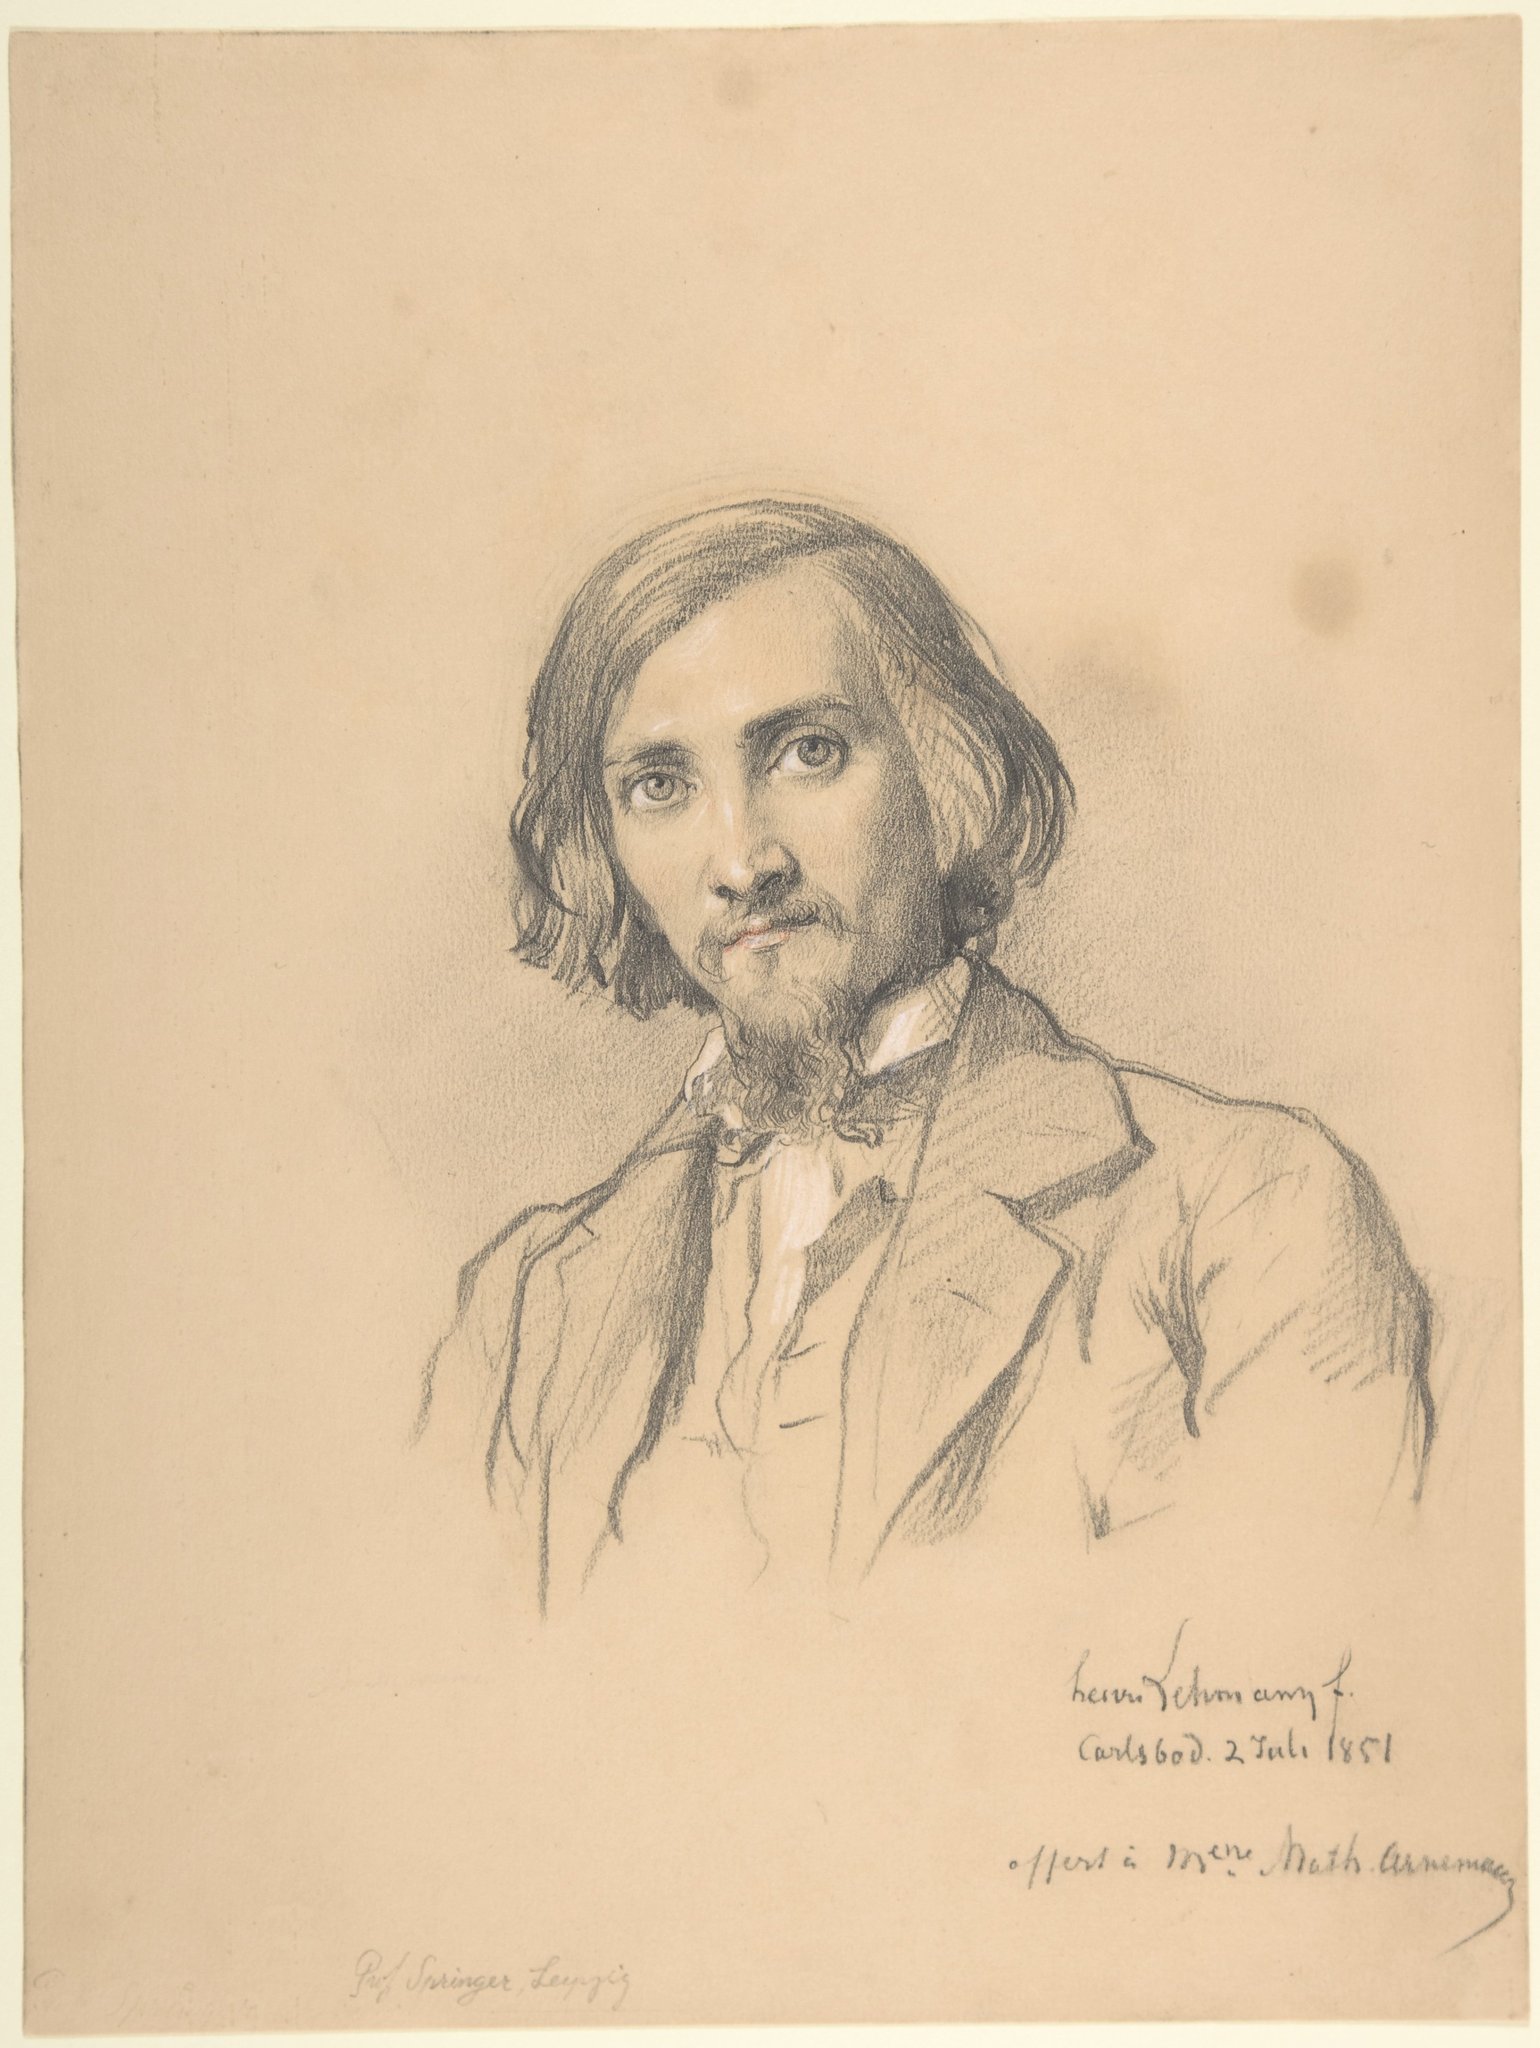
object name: drawing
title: Portrait of Anton Heinrich Springer (1825–1895)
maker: henri lehmann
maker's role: artist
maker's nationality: french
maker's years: 1814-1882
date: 1834-1866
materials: chalk, graphite, paper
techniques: heightening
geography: france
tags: men,portraits